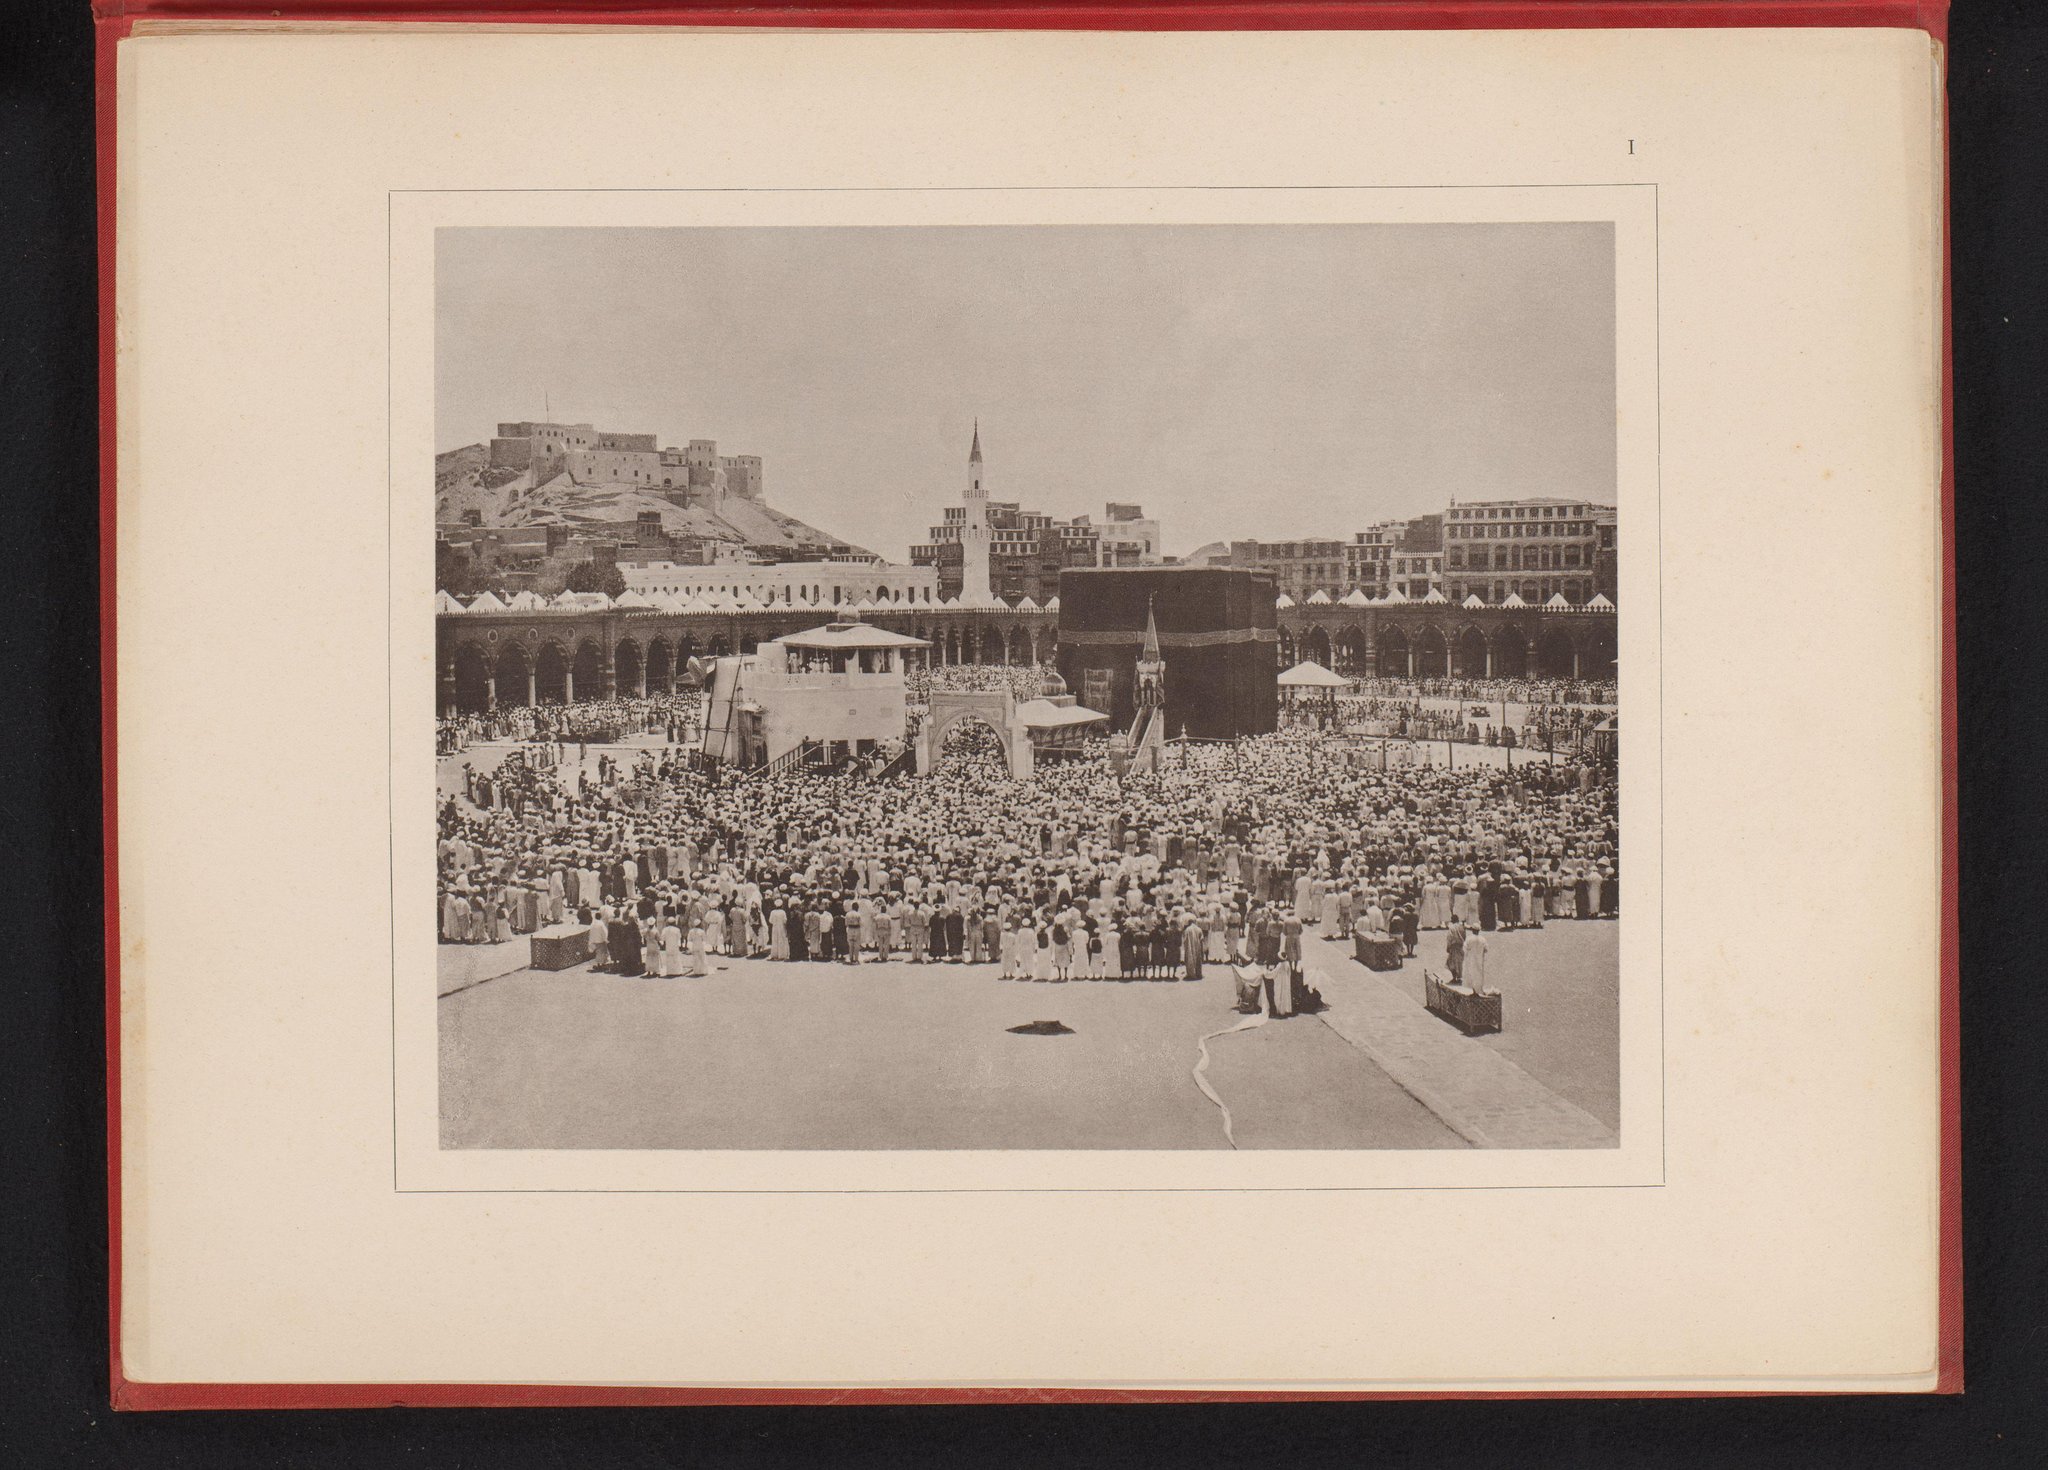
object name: album leaf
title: Gezicht op de Ka'aba in Mekka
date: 1889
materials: cardboard, paper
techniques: photograph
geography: mecca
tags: temple, shrine ~ islam, mohammedanism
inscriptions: number: ‘I’